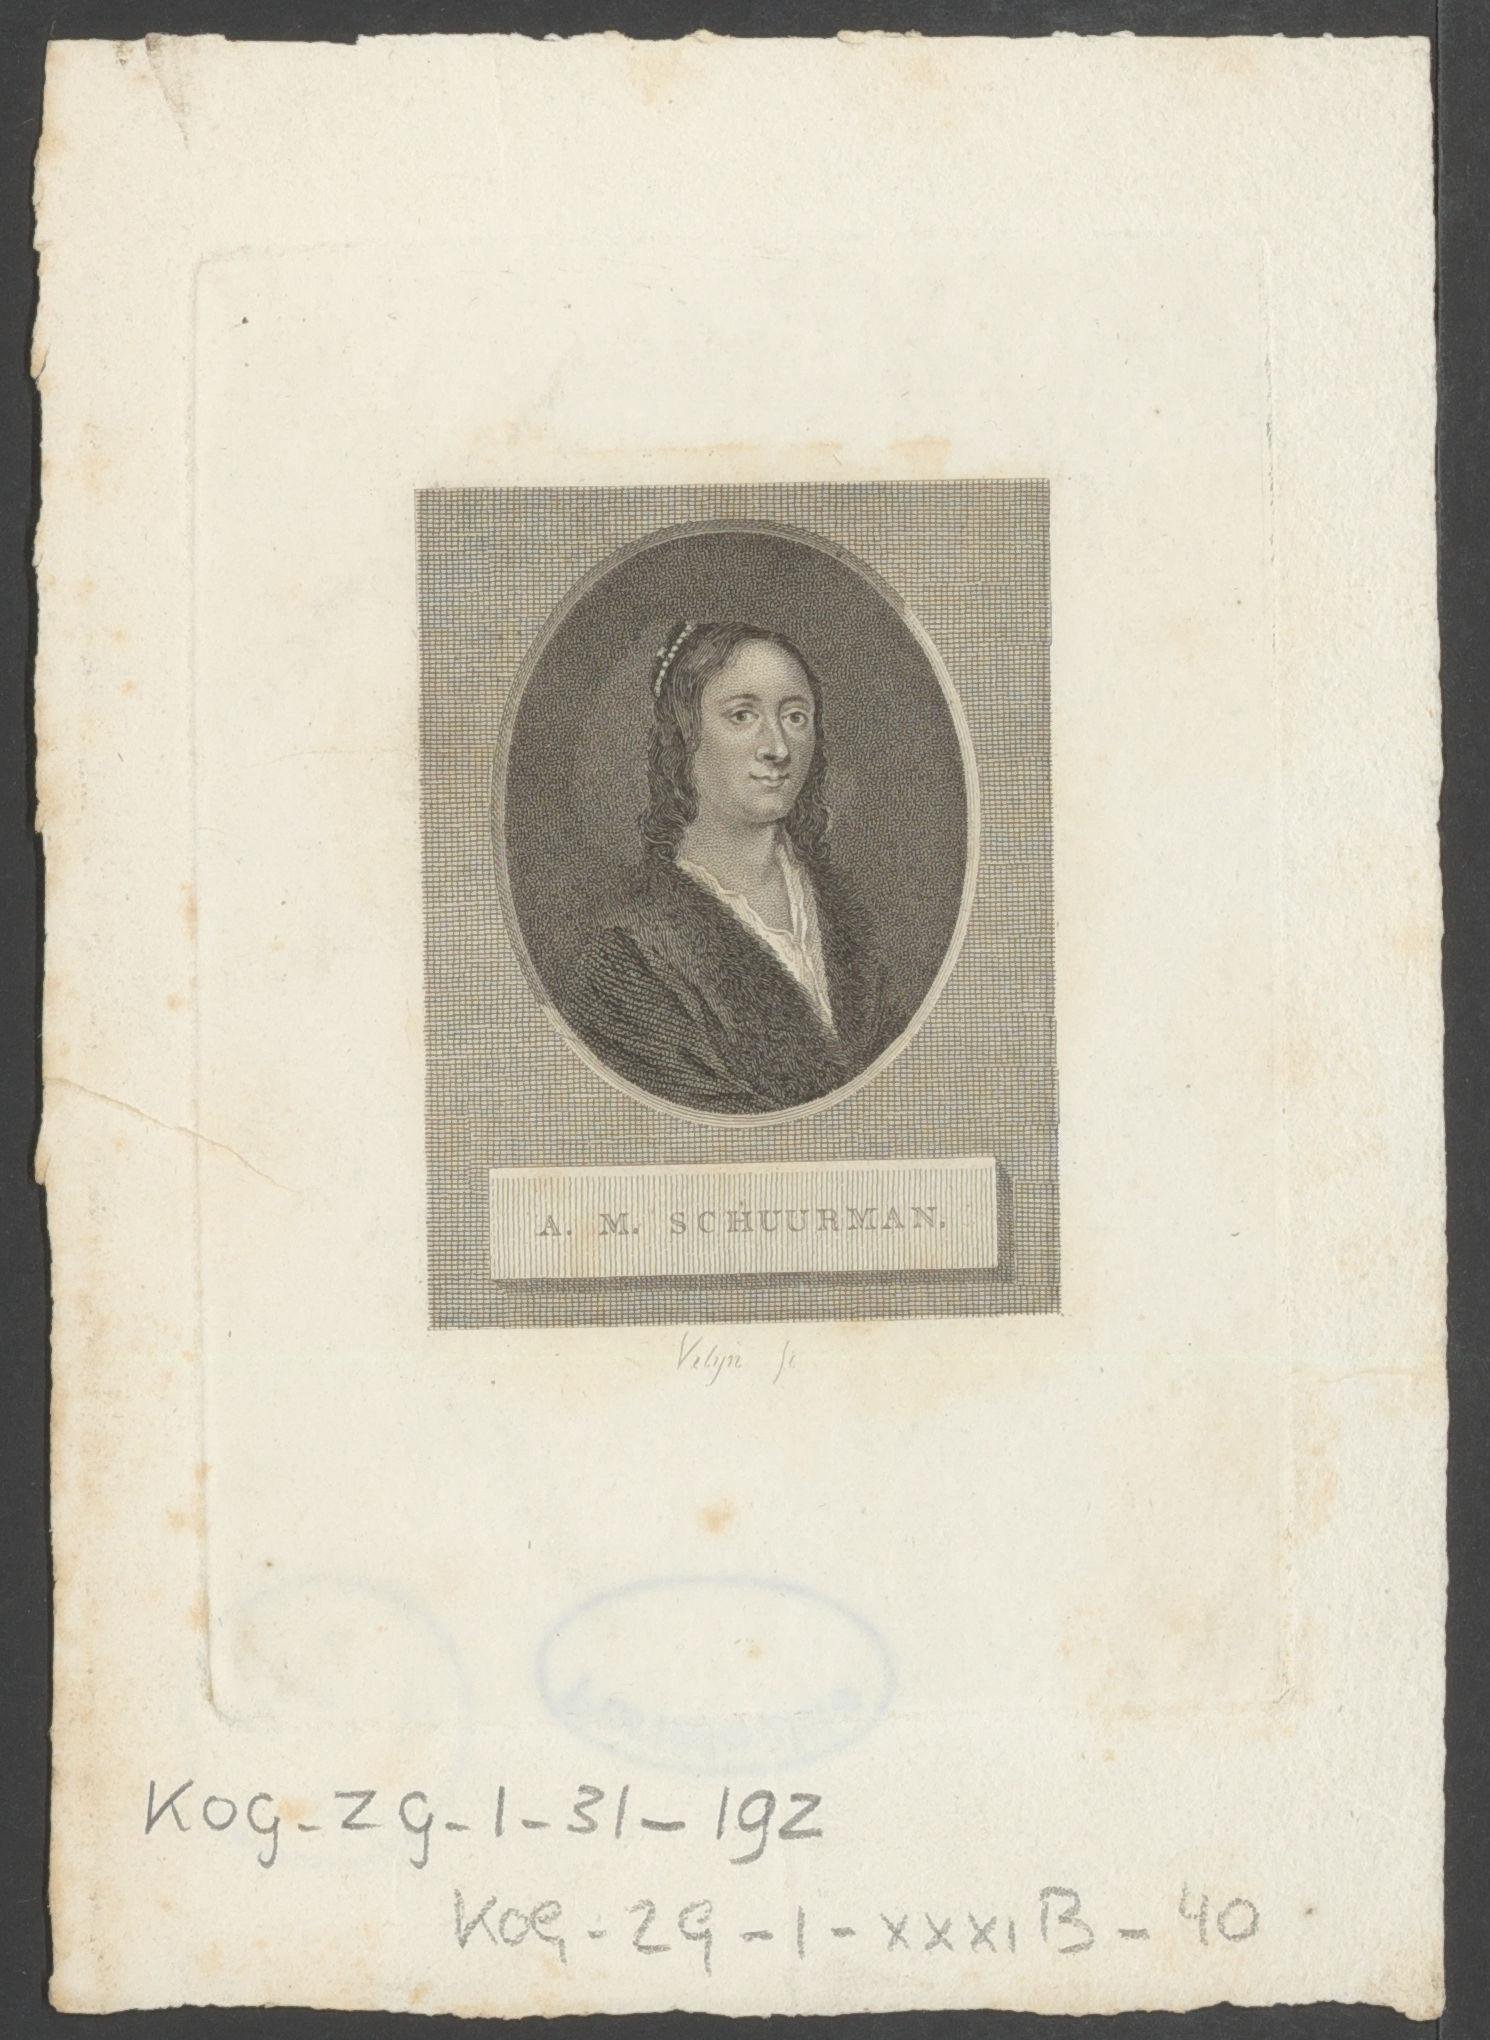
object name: print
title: Portret van Anna Maria van Schurman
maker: philippus velijn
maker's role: print maker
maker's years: 1787-1836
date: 1799-1836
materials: paper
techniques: etching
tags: cologne, draughtsman, anna maria van schurman, historical persons - bb - woman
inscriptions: stamp, collector's mark: Lugt 1641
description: Onderwerpsrubrieken binnen de Atlas Zeden en Gewoonten: Portretten, Portretten van bijzondere personen.